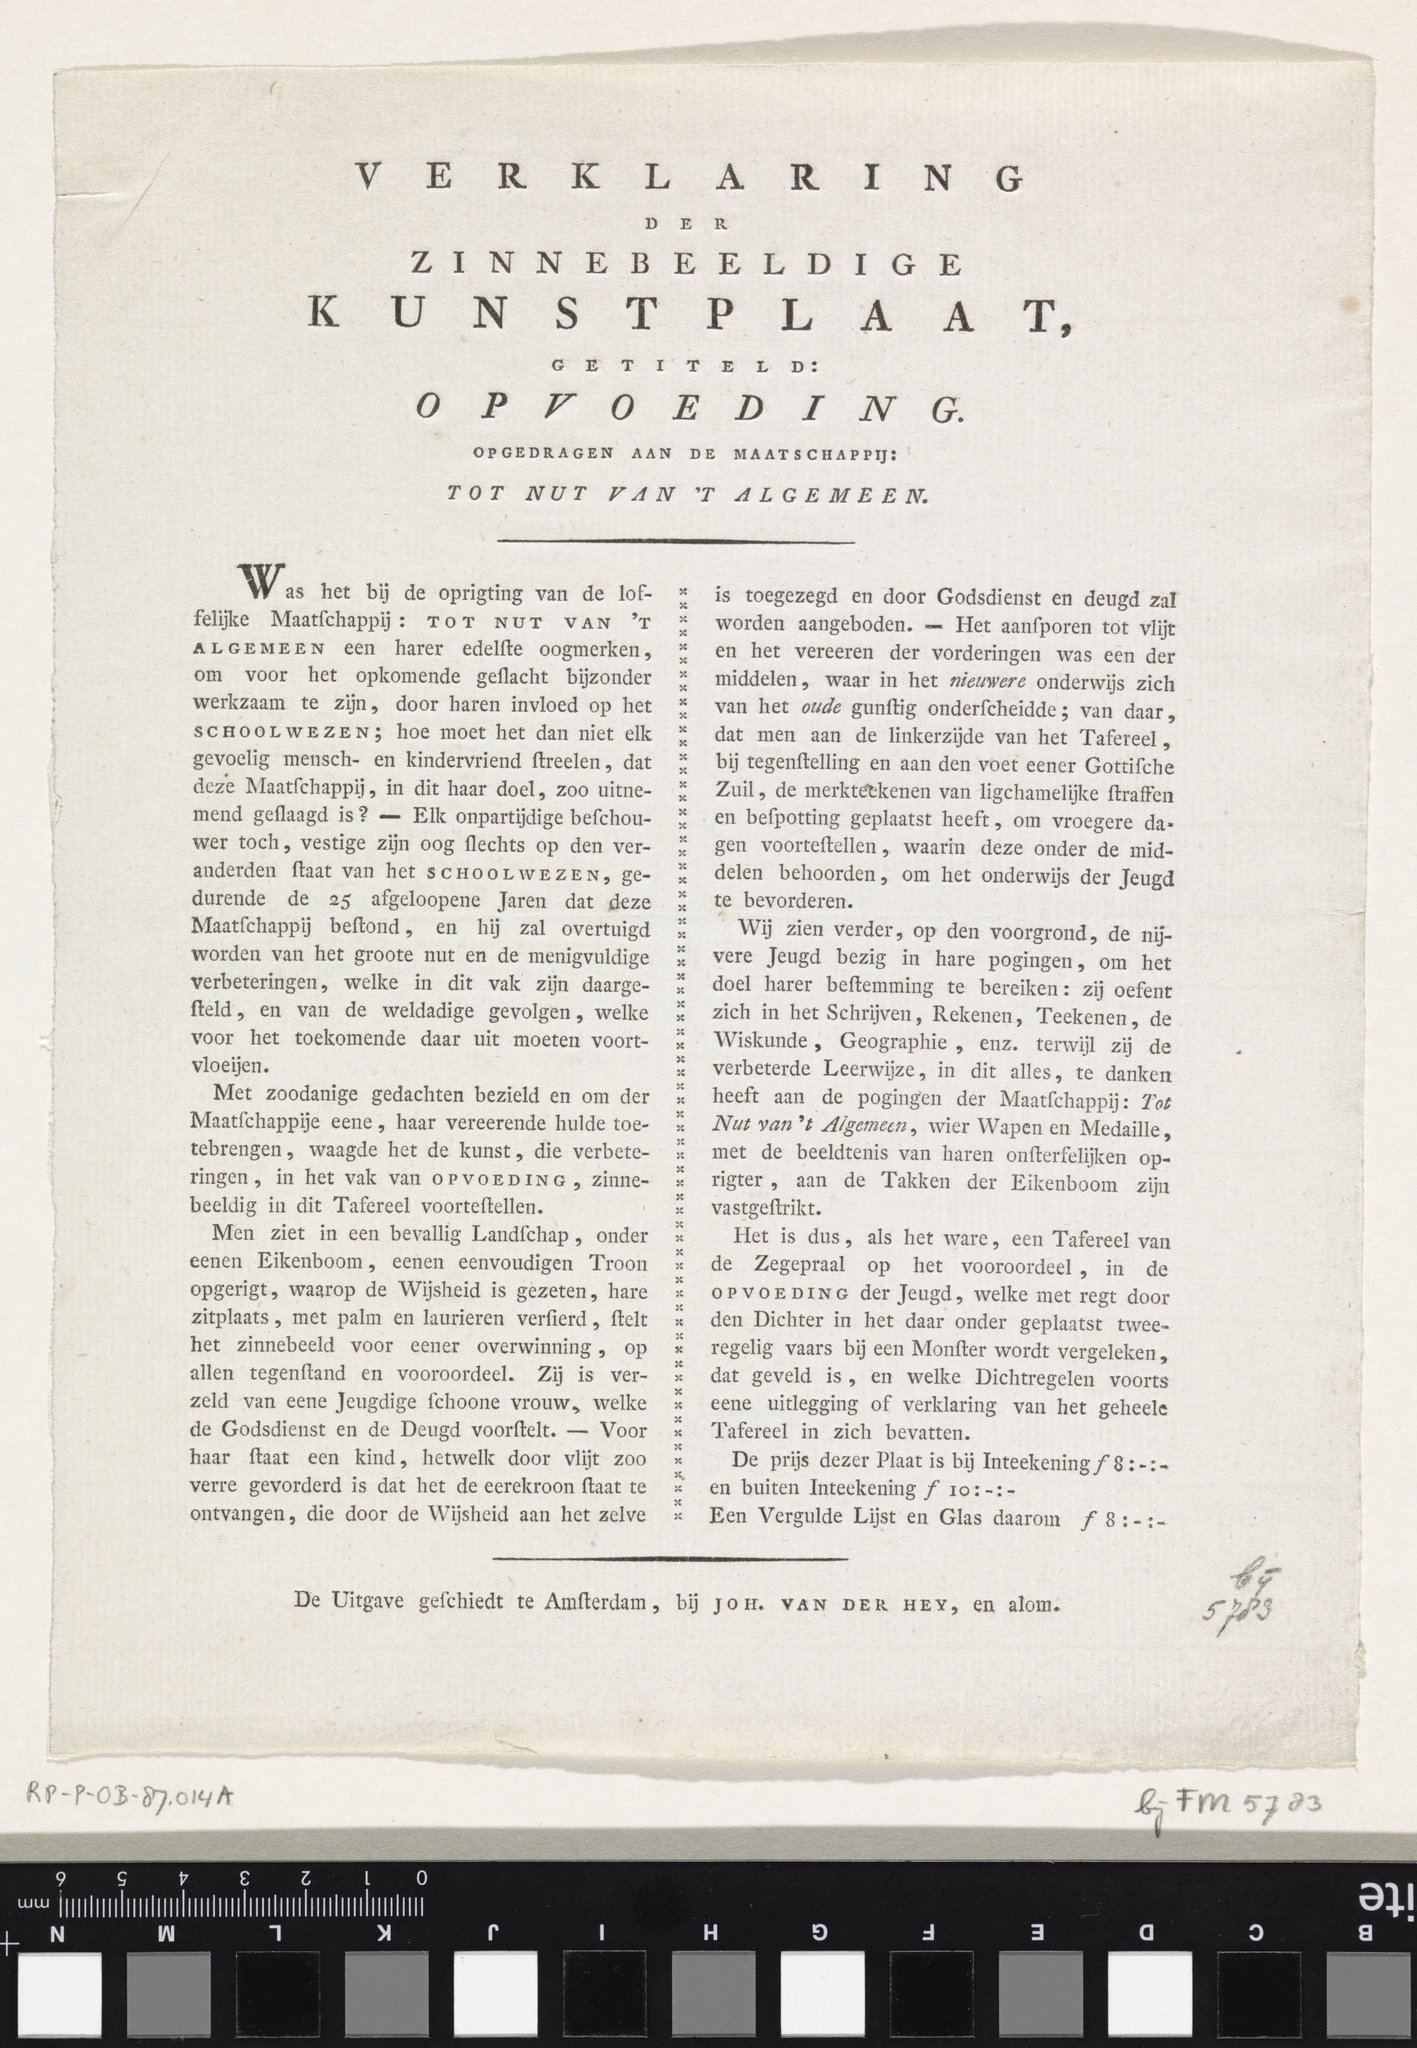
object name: text sheet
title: Verklaring der zinnebeeldige kunstplaat, getiteld: Opvoeding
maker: johannes van der hey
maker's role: publisher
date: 1809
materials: paper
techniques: letterpress printing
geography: amsterdam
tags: symbolic representations, allegories and emblems ~ education; 'ammaestramento', dottrina', 'educatione', 'istitutione' (ripa)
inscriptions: collector's mark: Lugt 2228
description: Tekstblad met een verklaring van de voorstelling van de prent met de allegorie op het onderwijs, uitgegeven bij het 25-jarig bestaan van het Maatschappij tot Nut van 't Algemeen, op 16 november 1809. Met prijslijst.